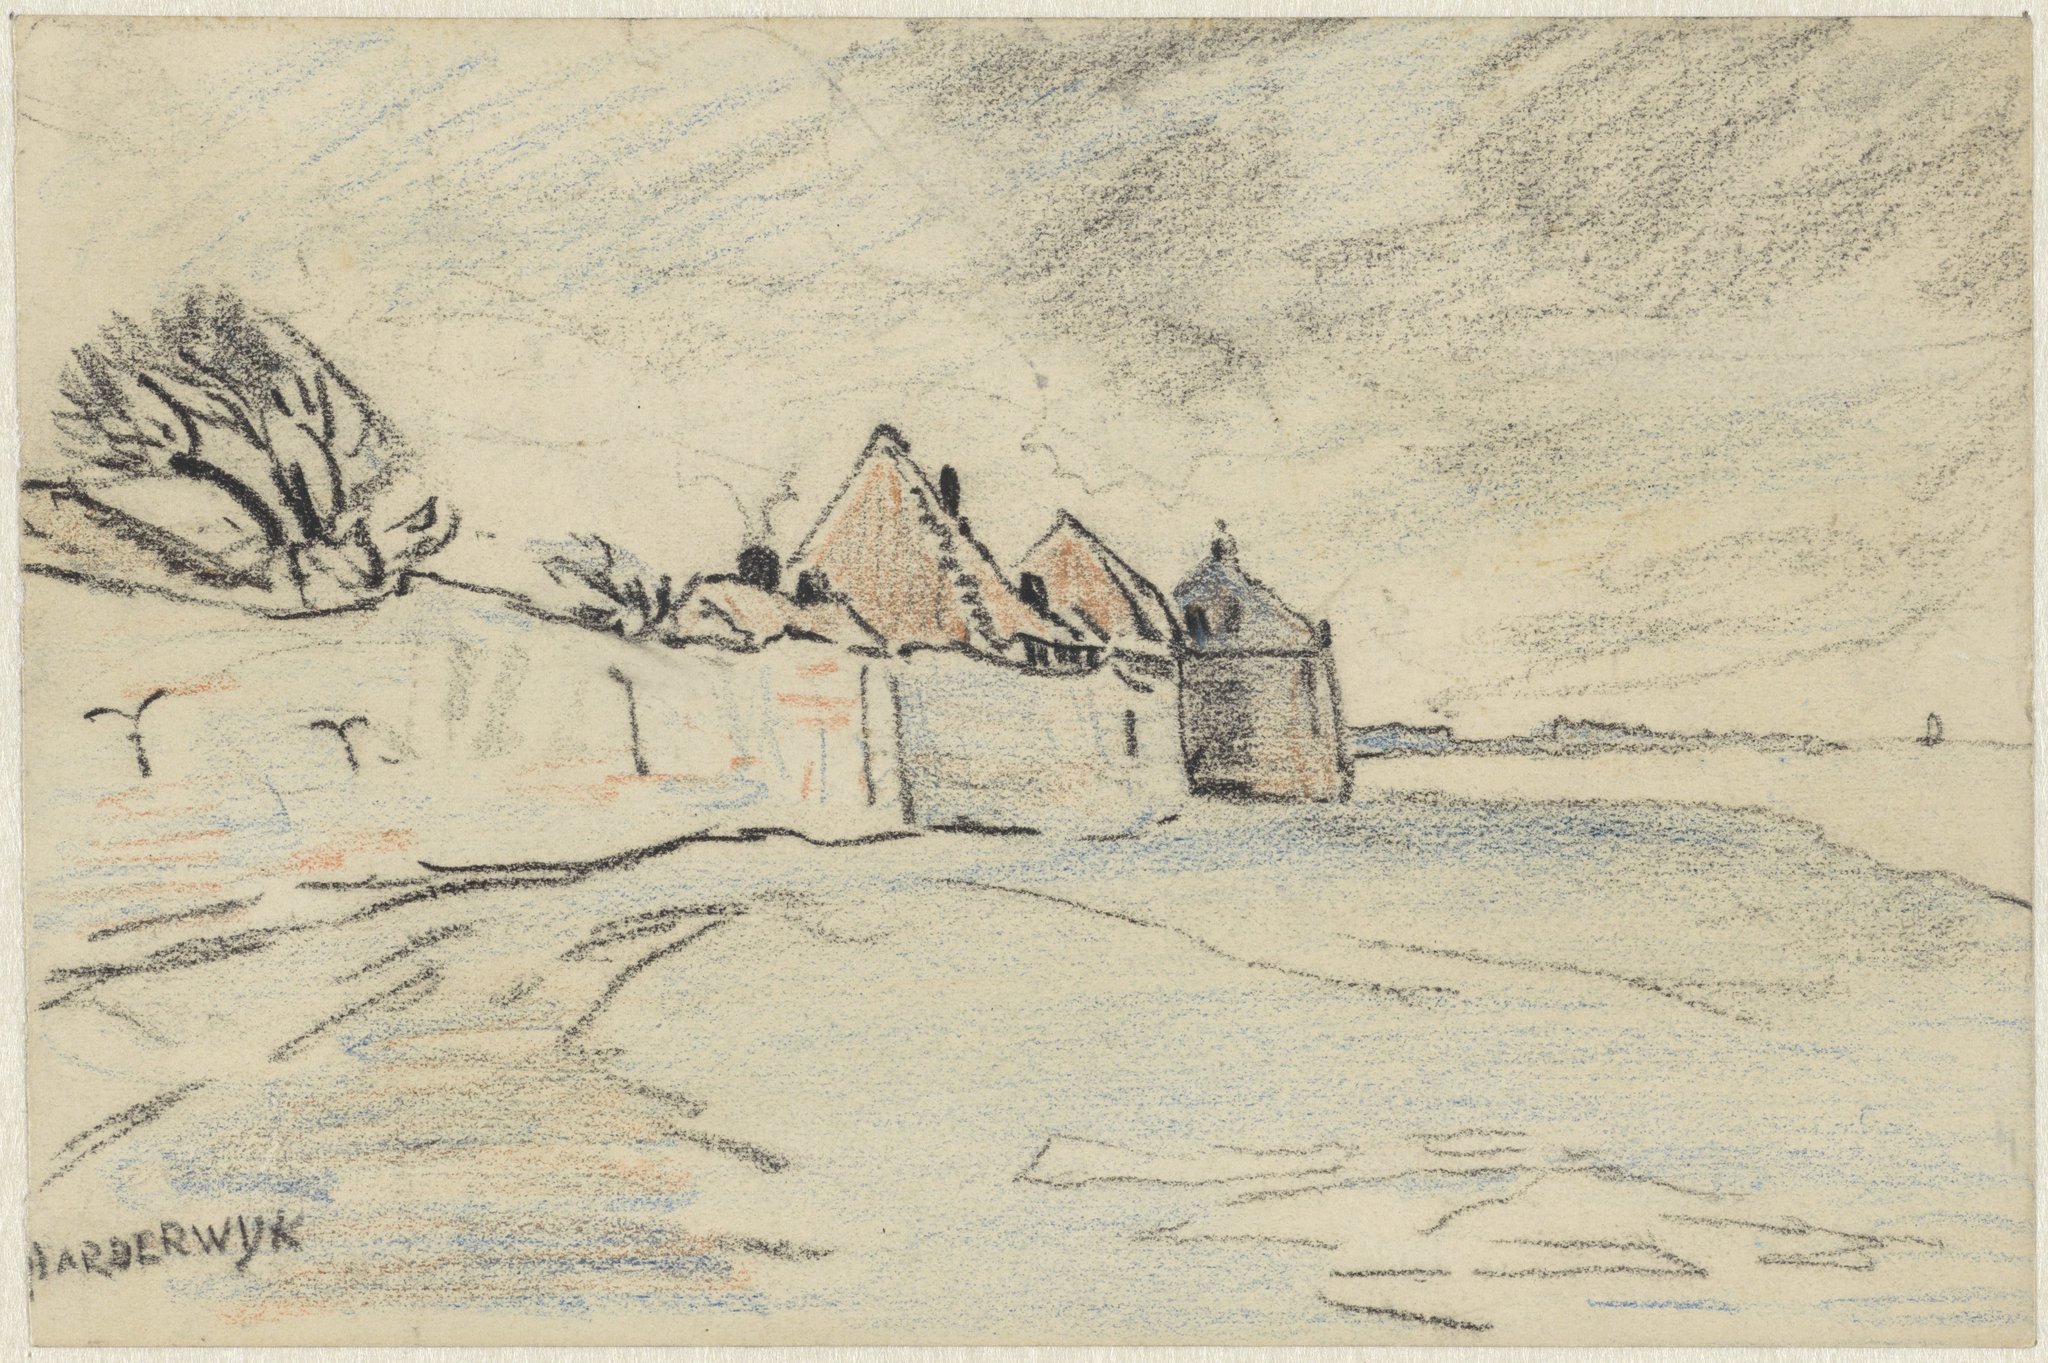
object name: drawing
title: Stadswallen van Harderwijk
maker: adolf le comte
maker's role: draughtsman, painter, print maker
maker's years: 1850-1921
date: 1860-1921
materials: chalk, paper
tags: city-walls